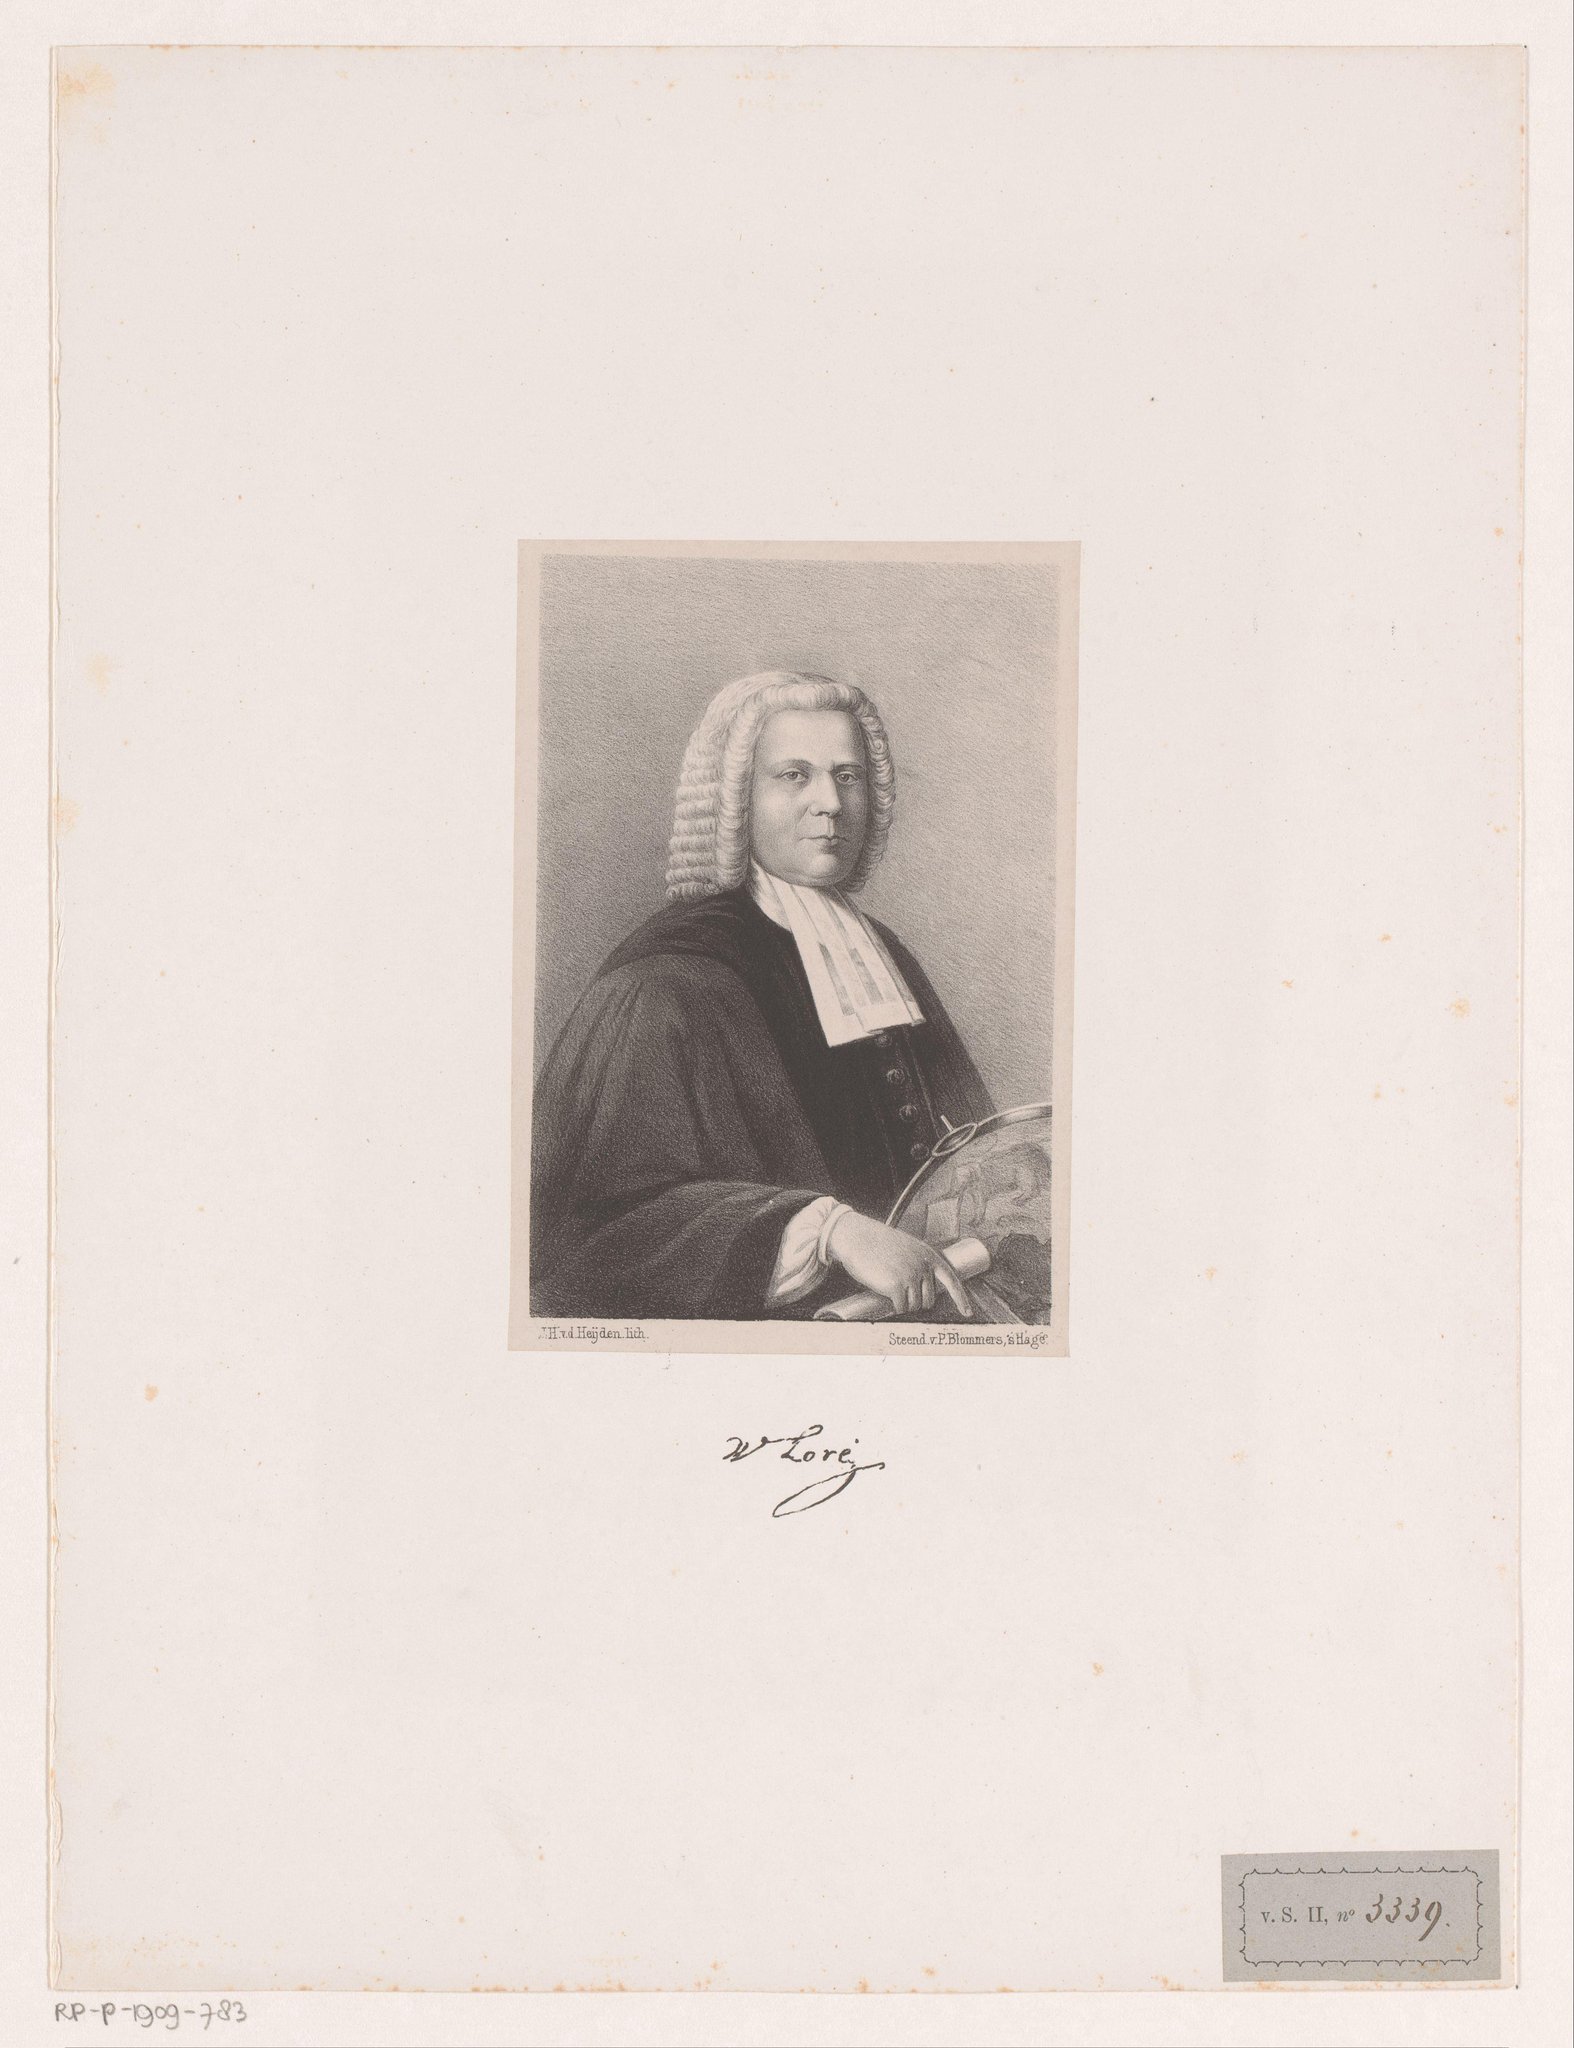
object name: print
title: Portret van landmeter en hoogleraar in de wiskunde W. Loré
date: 1842-1887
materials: paper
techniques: lithograph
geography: the hague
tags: globe, historical persons (+ (full) bust portrait)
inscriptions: collector's mark: Lugt 2228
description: De geportretteerde draagt een pruik, bef en toga. Hij heeft een rol papier in zijn rechterhand en wijst op een globe.